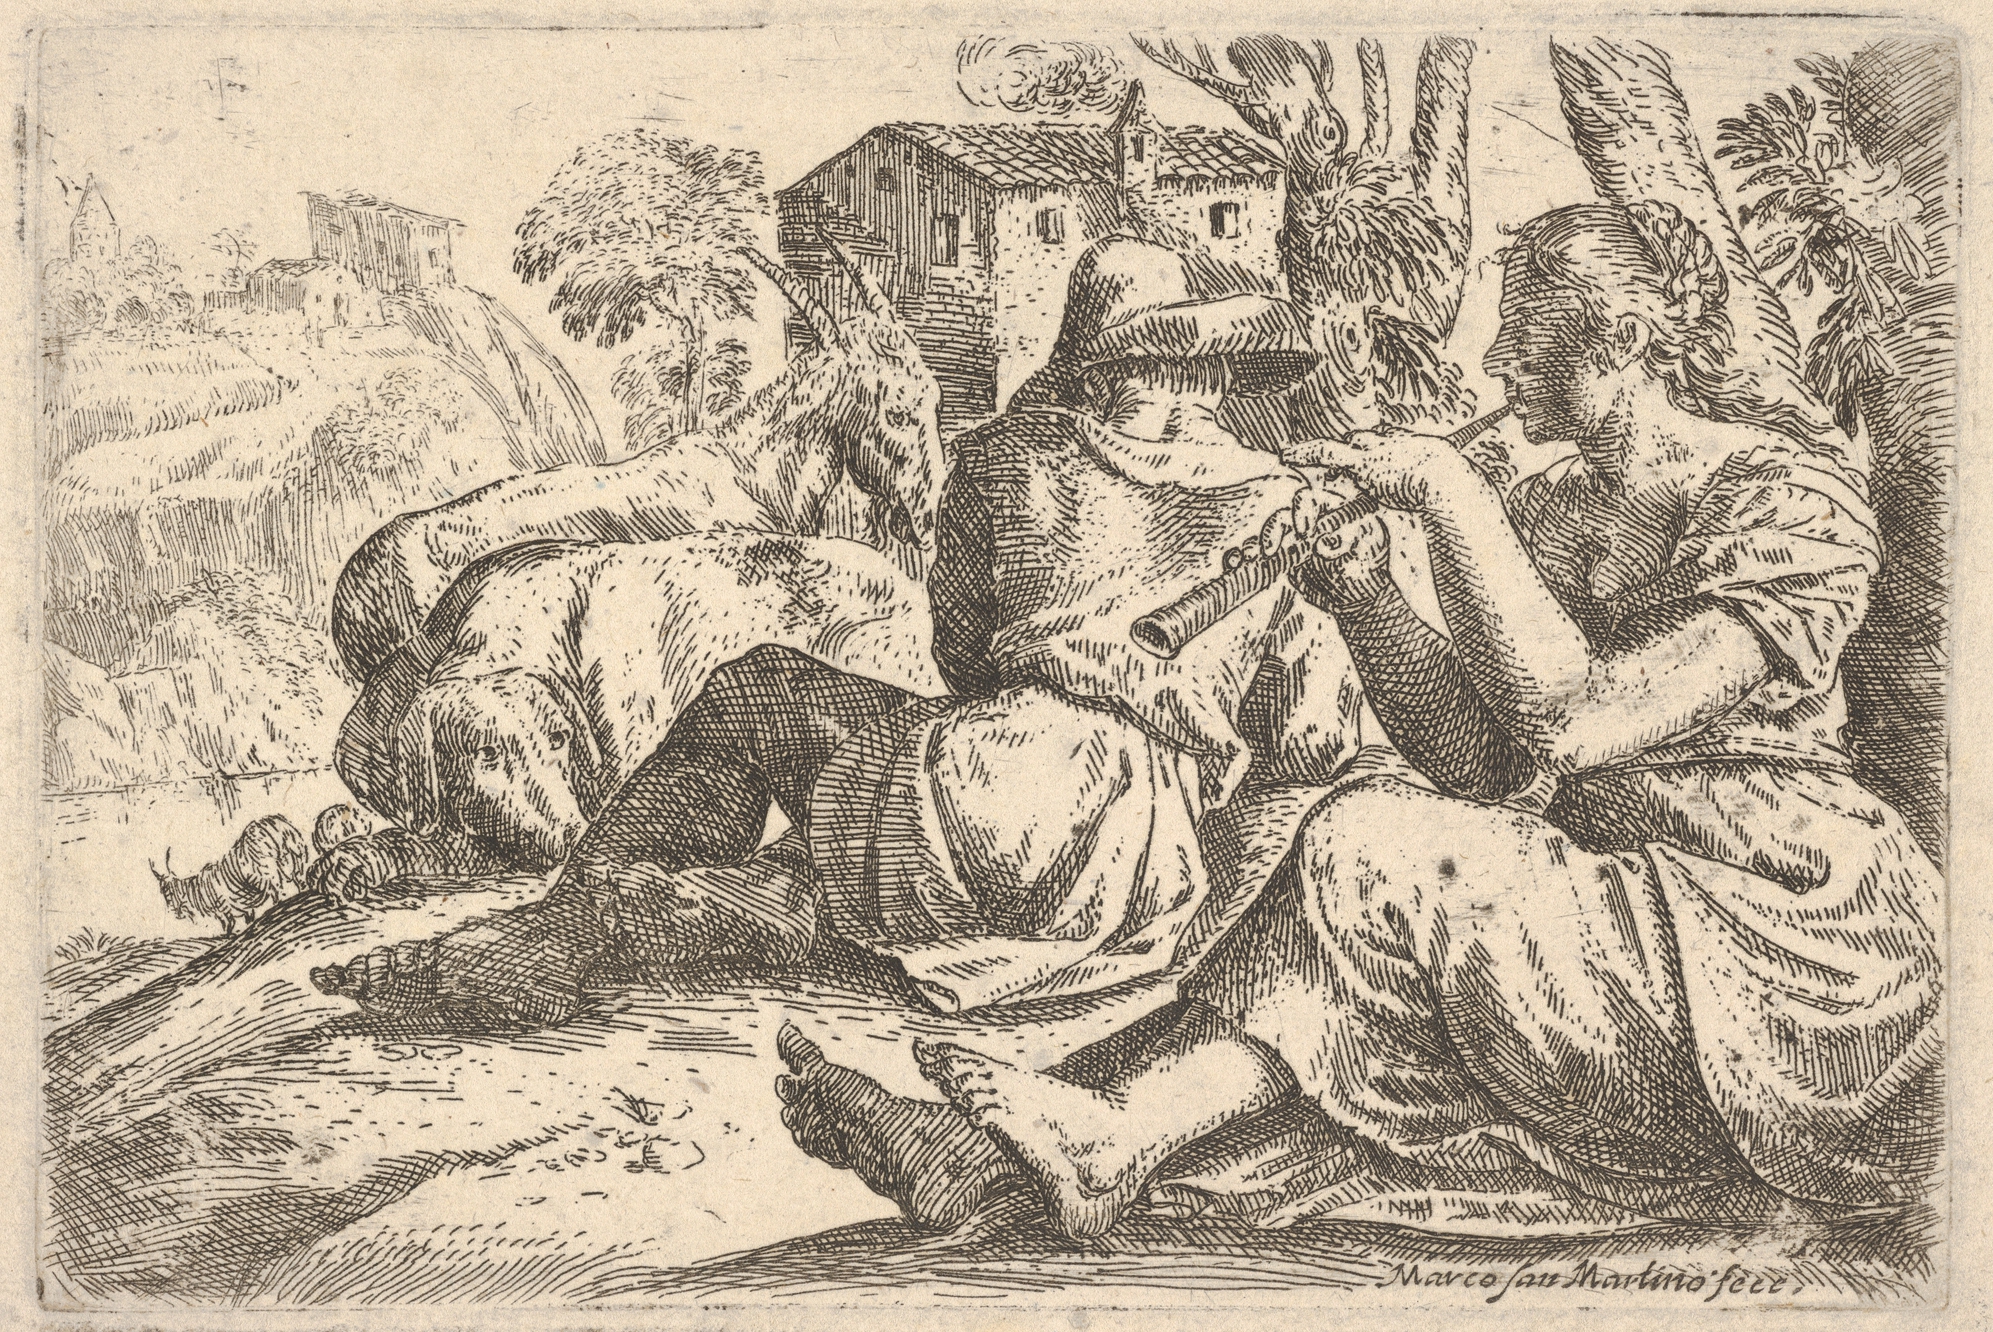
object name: print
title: Shepherd and Shepherdess, Playing Flute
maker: marco san martino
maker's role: artist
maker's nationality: italian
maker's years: 1615-1700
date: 1625-1700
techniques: etching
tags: animals,women,flutes,shepherds